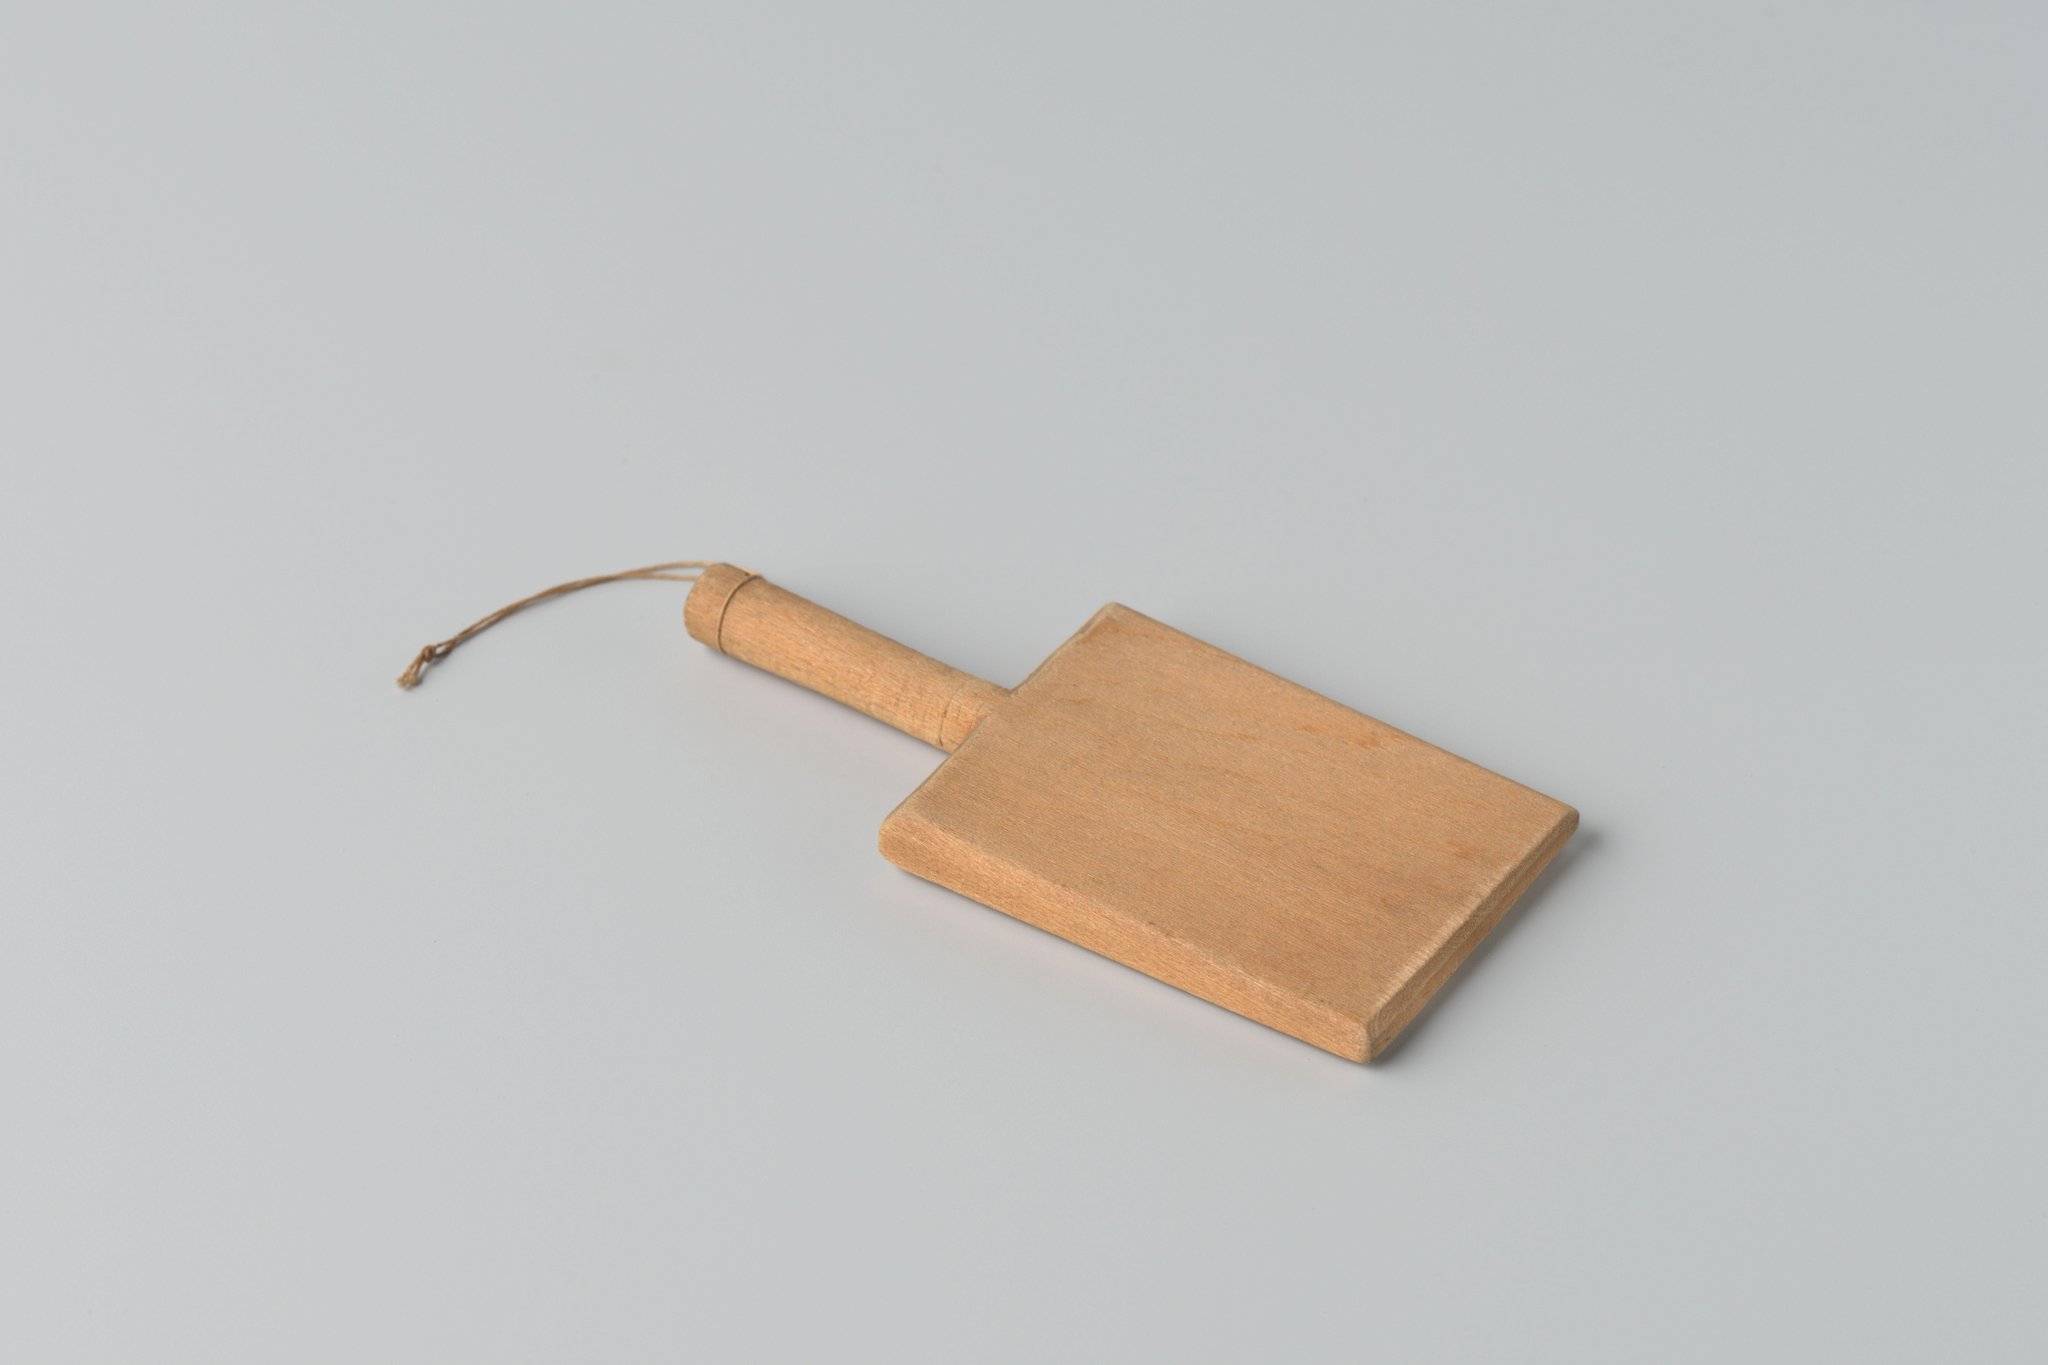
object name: miniature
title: Strijk- of vouwplank van without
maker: Anonymous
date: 1676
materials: without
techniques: without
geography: amsterdam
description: Strijk- of vouwplank van without met ronde steel, waaromheen een draad is geknoopt. De plank wordt naar de steel toe dikker.